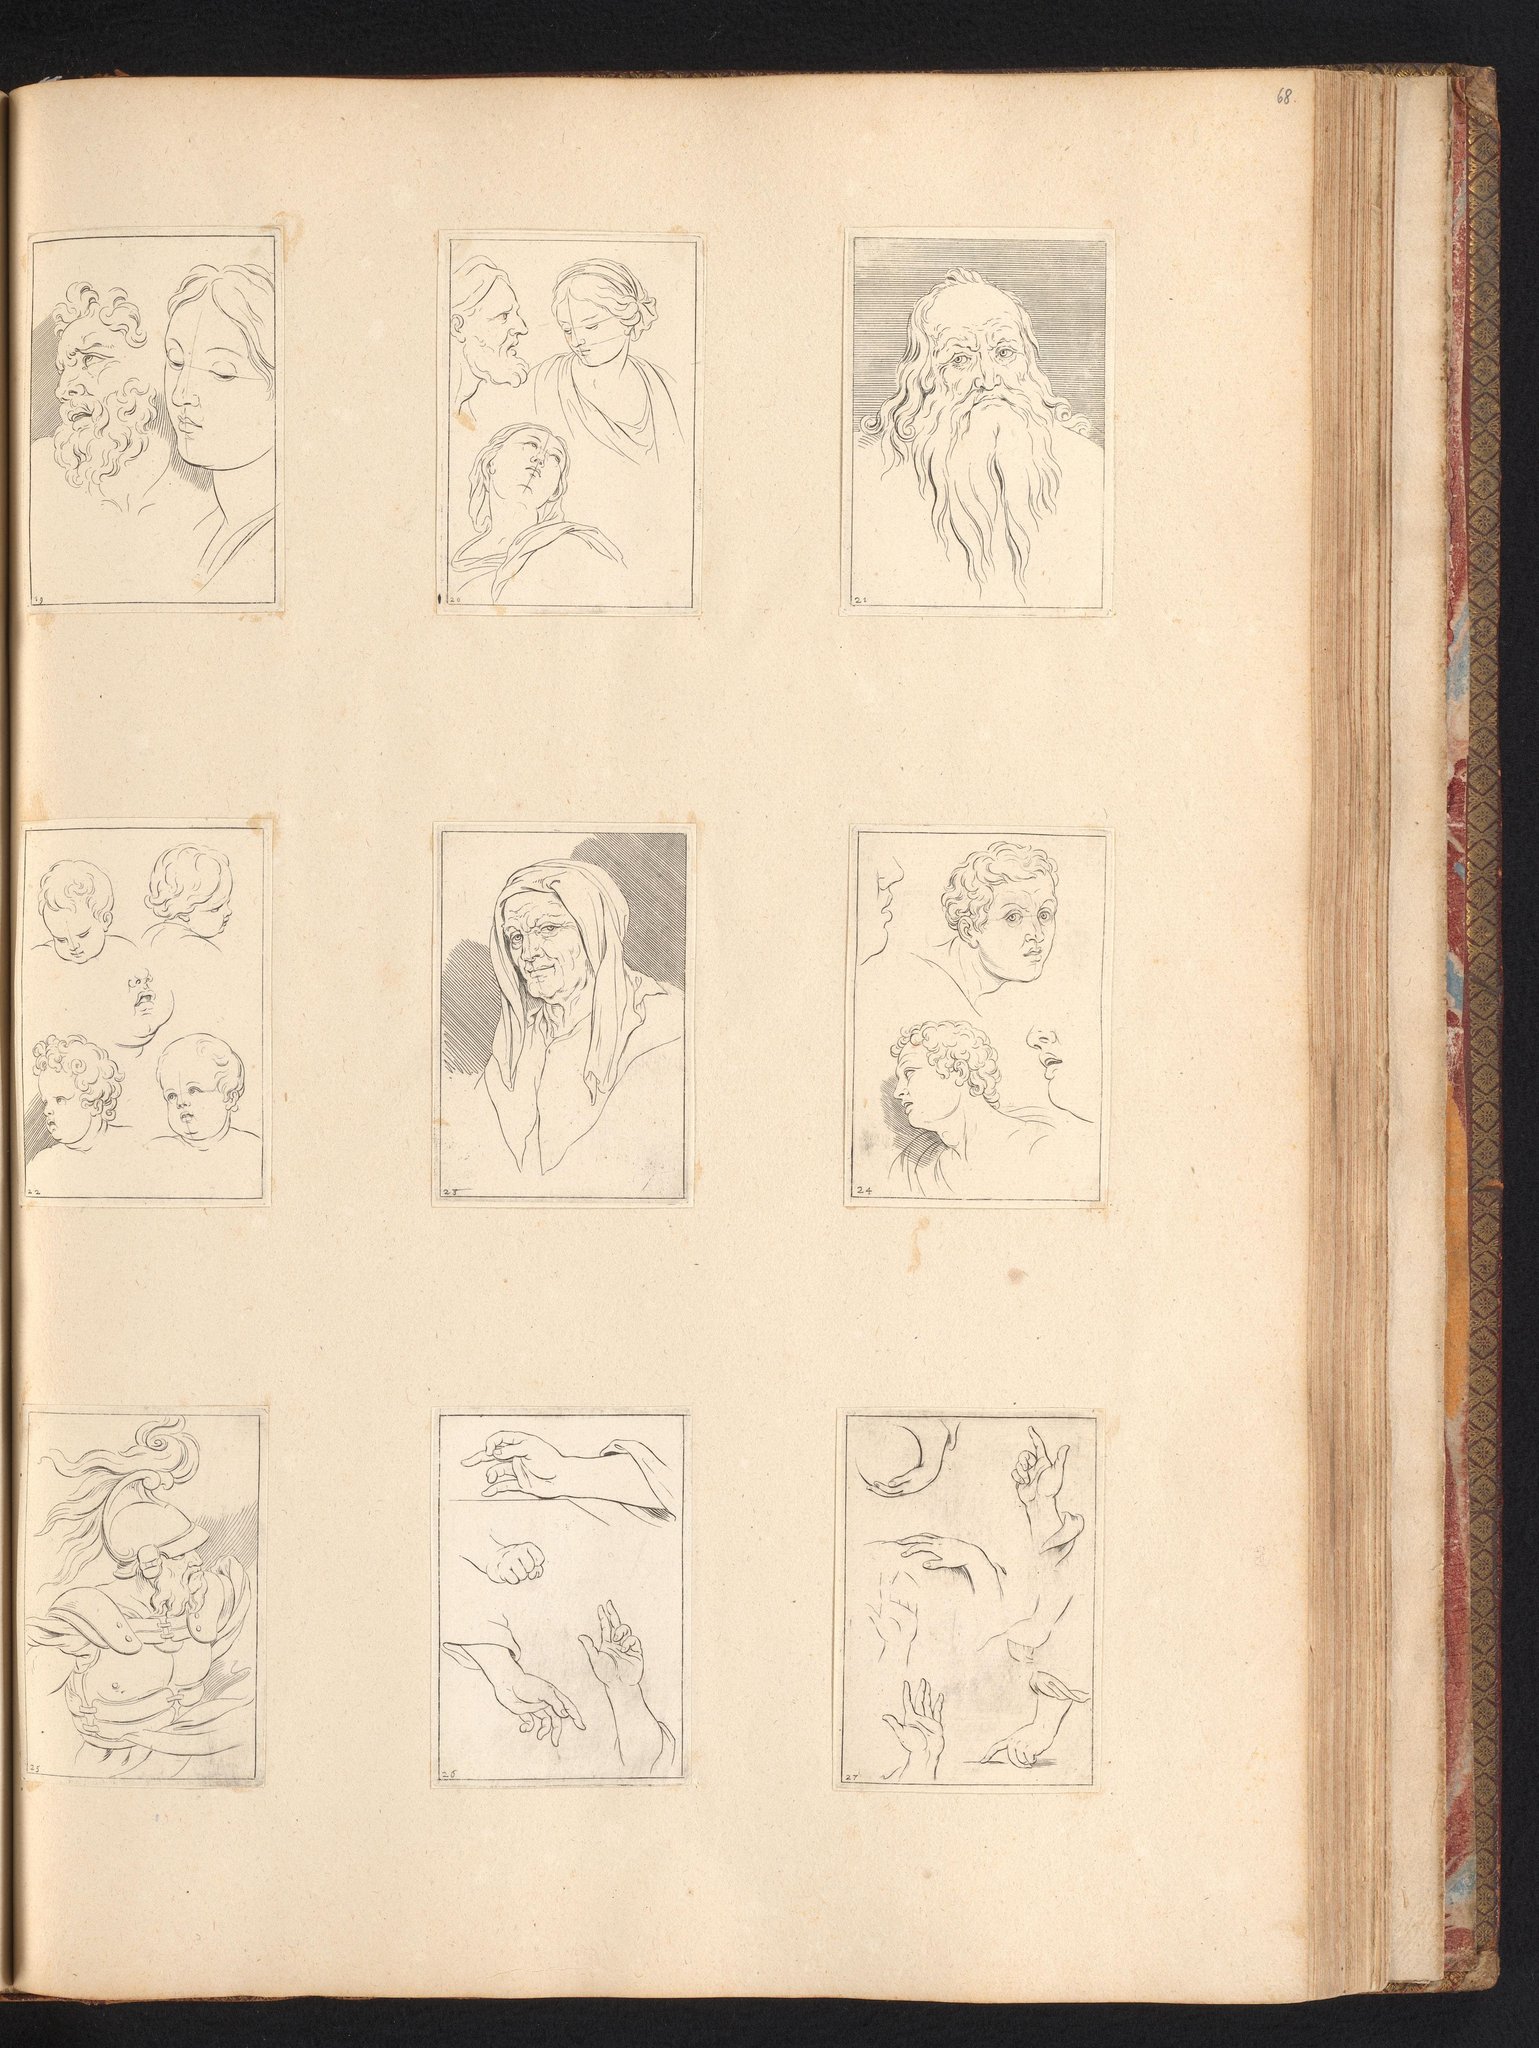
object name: print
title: Negen tekenvoorbeelden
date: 1700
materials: paper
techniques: engraving, etching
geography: france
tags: model-books ~ implements of painter, tools, implements of draughtsman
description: Negen tekenvoorbeelden van handen en hoofden van mannen, vrouwen en kinderen. Alle negen prenten zijn linksonder genummerd van 19 t/m 27. Deze negen prenten maken deel uit van een album.